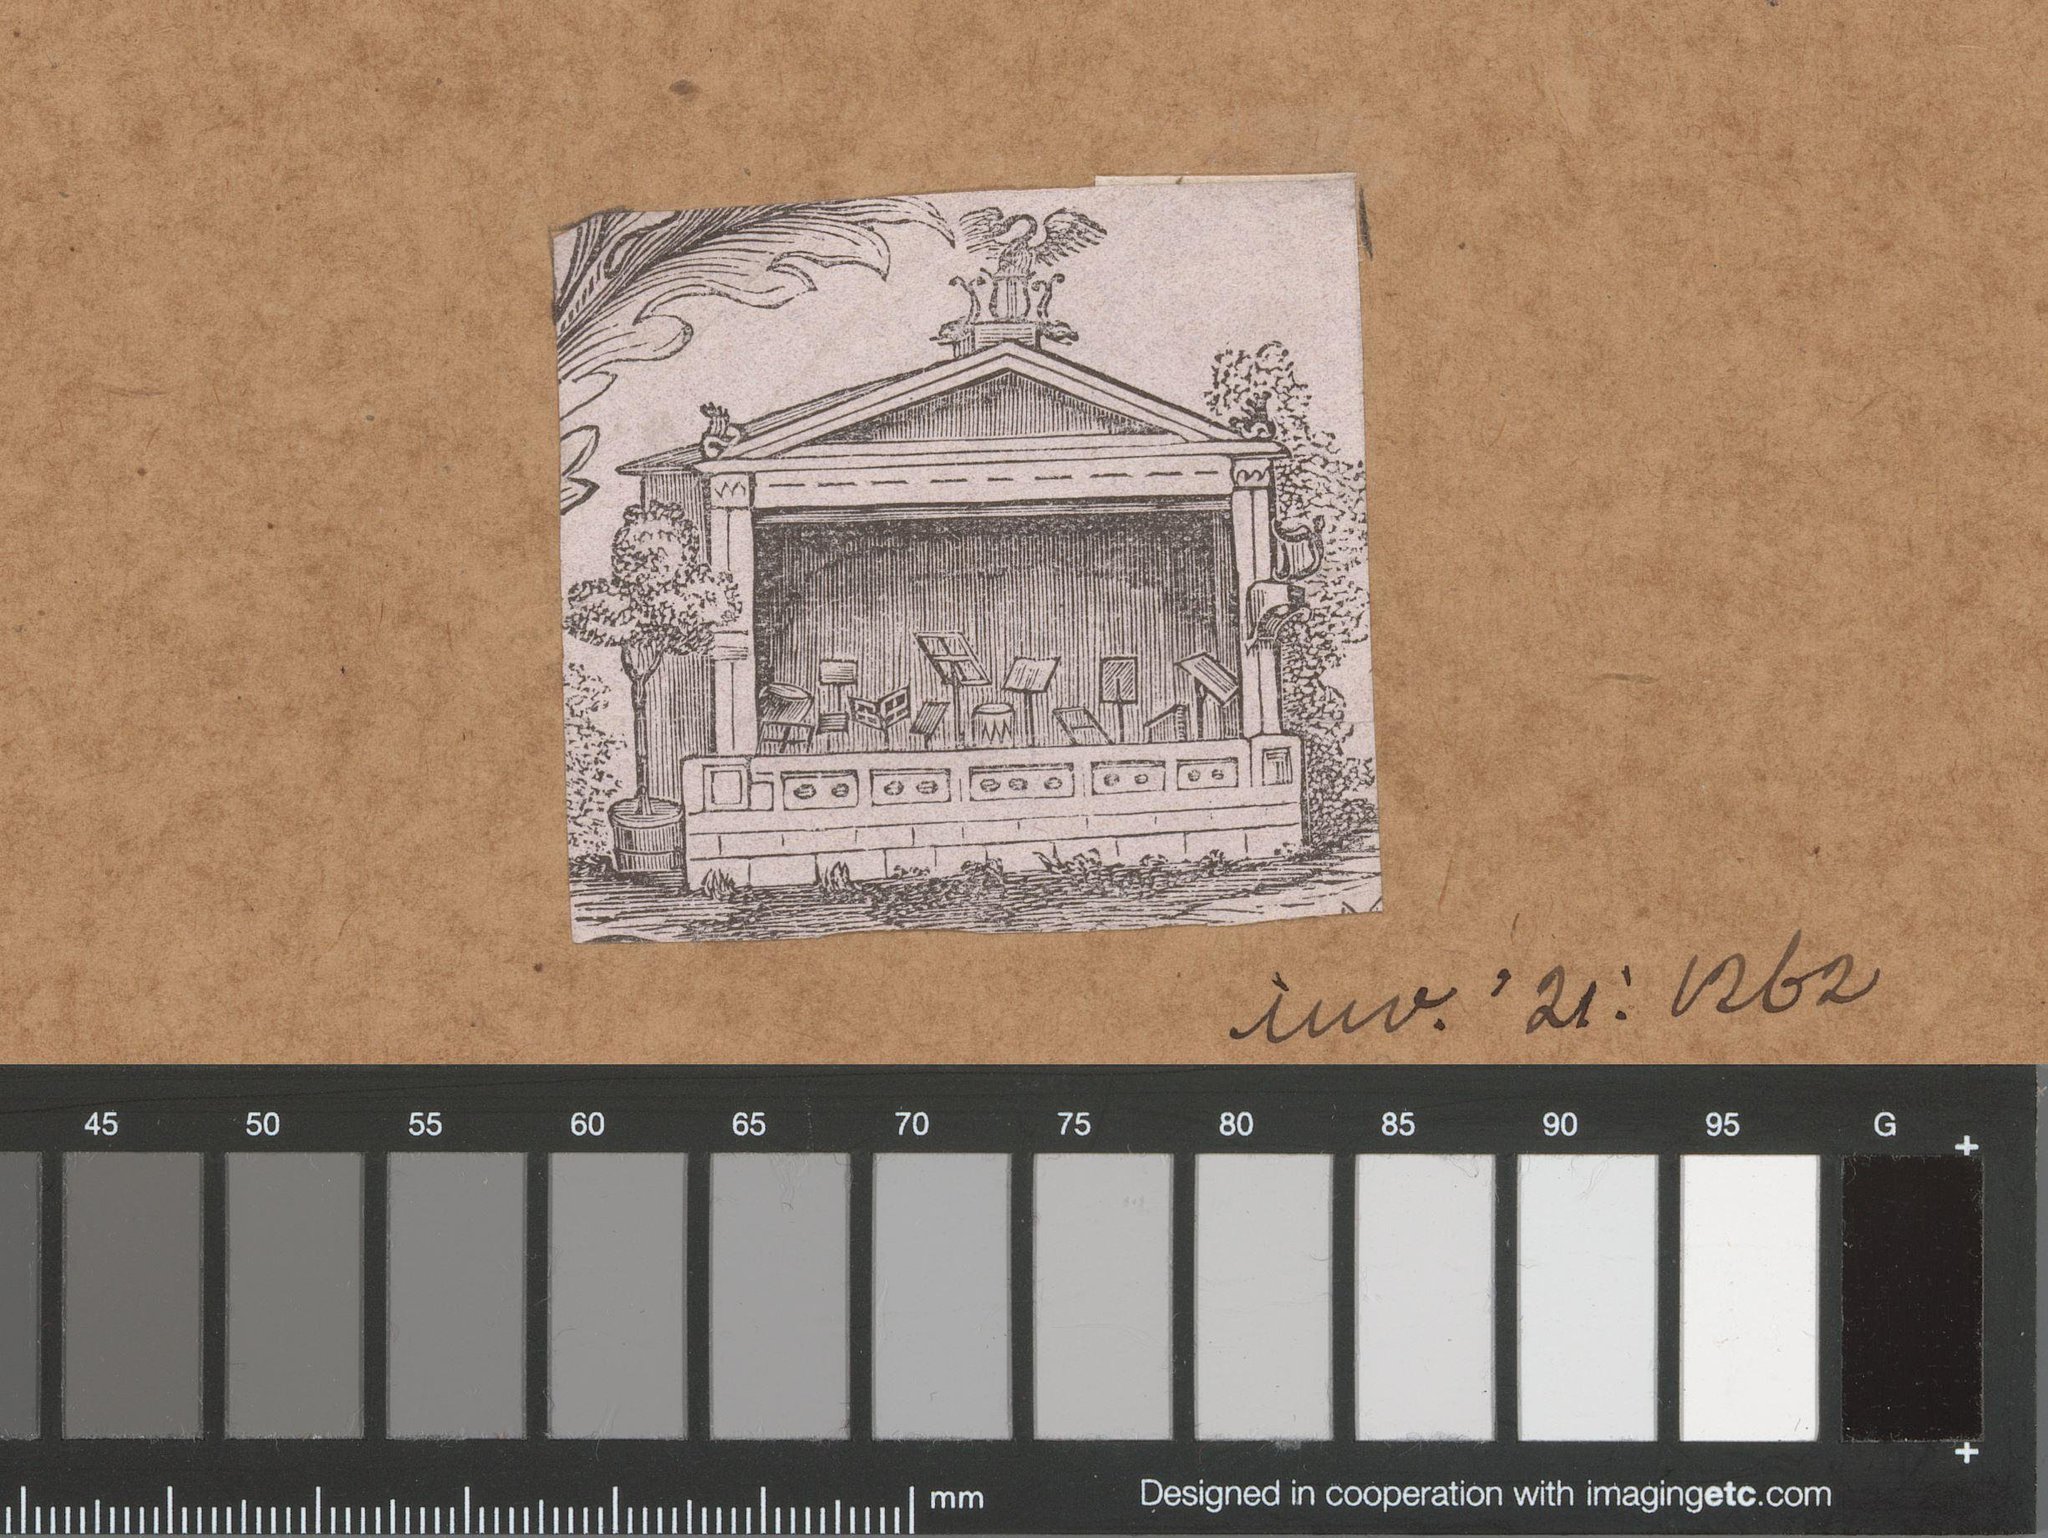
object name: print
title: Muziektent met stoelen en muziekstandaards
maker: Anonymous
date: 1853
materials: paper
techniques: engraving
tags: bandstand, amsterdam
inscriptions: annotation: ‘Orkest in het Park. 1853’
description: De handgeschreven annotatie op het verso duidt wellicht op het Parkorkest, in 1849 in Amsterdam opgericht. Dan is deze afbeelding mogelijk te situeren in wat tegenwoordig bekend staat als het Wertheimpark, aangezien daar de Parkzaal stond waar het Parkorkest optrad.